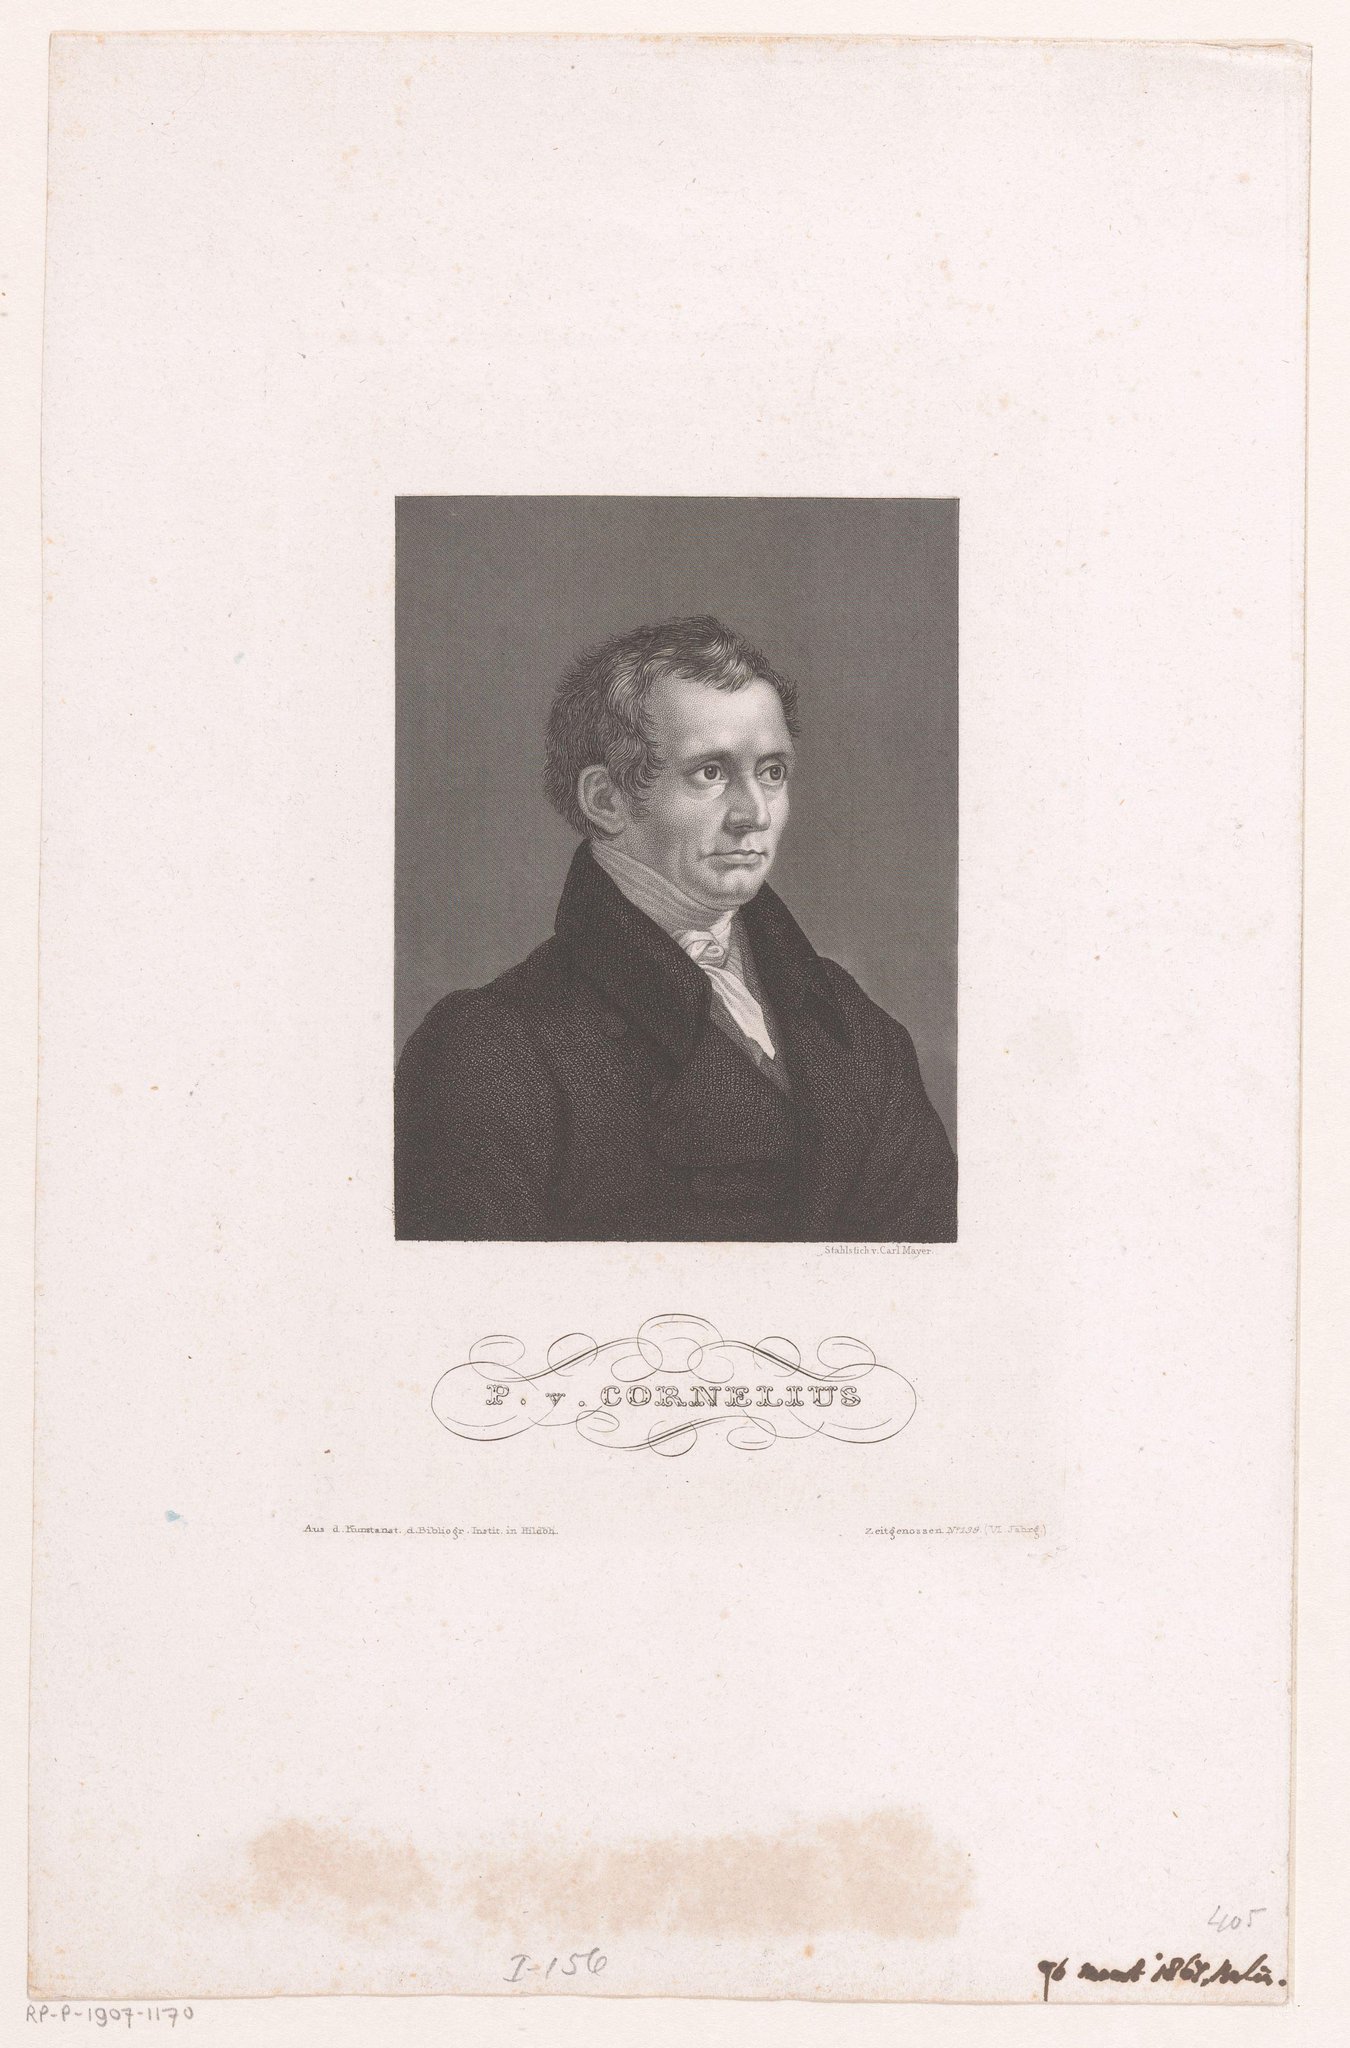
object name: print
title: Zeitgenossen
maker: carl mayer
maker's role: print maker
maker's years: 1798-1868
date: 1829-1840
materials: paper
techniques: engraving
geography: hildburghausen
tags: peter von cornelius, historical persons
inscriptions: collector's mark: Lugt 2228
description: Afkomstig uit de portretserie 'Zeitgenossen', uitgegeven tussen 1829 en circa 1840.